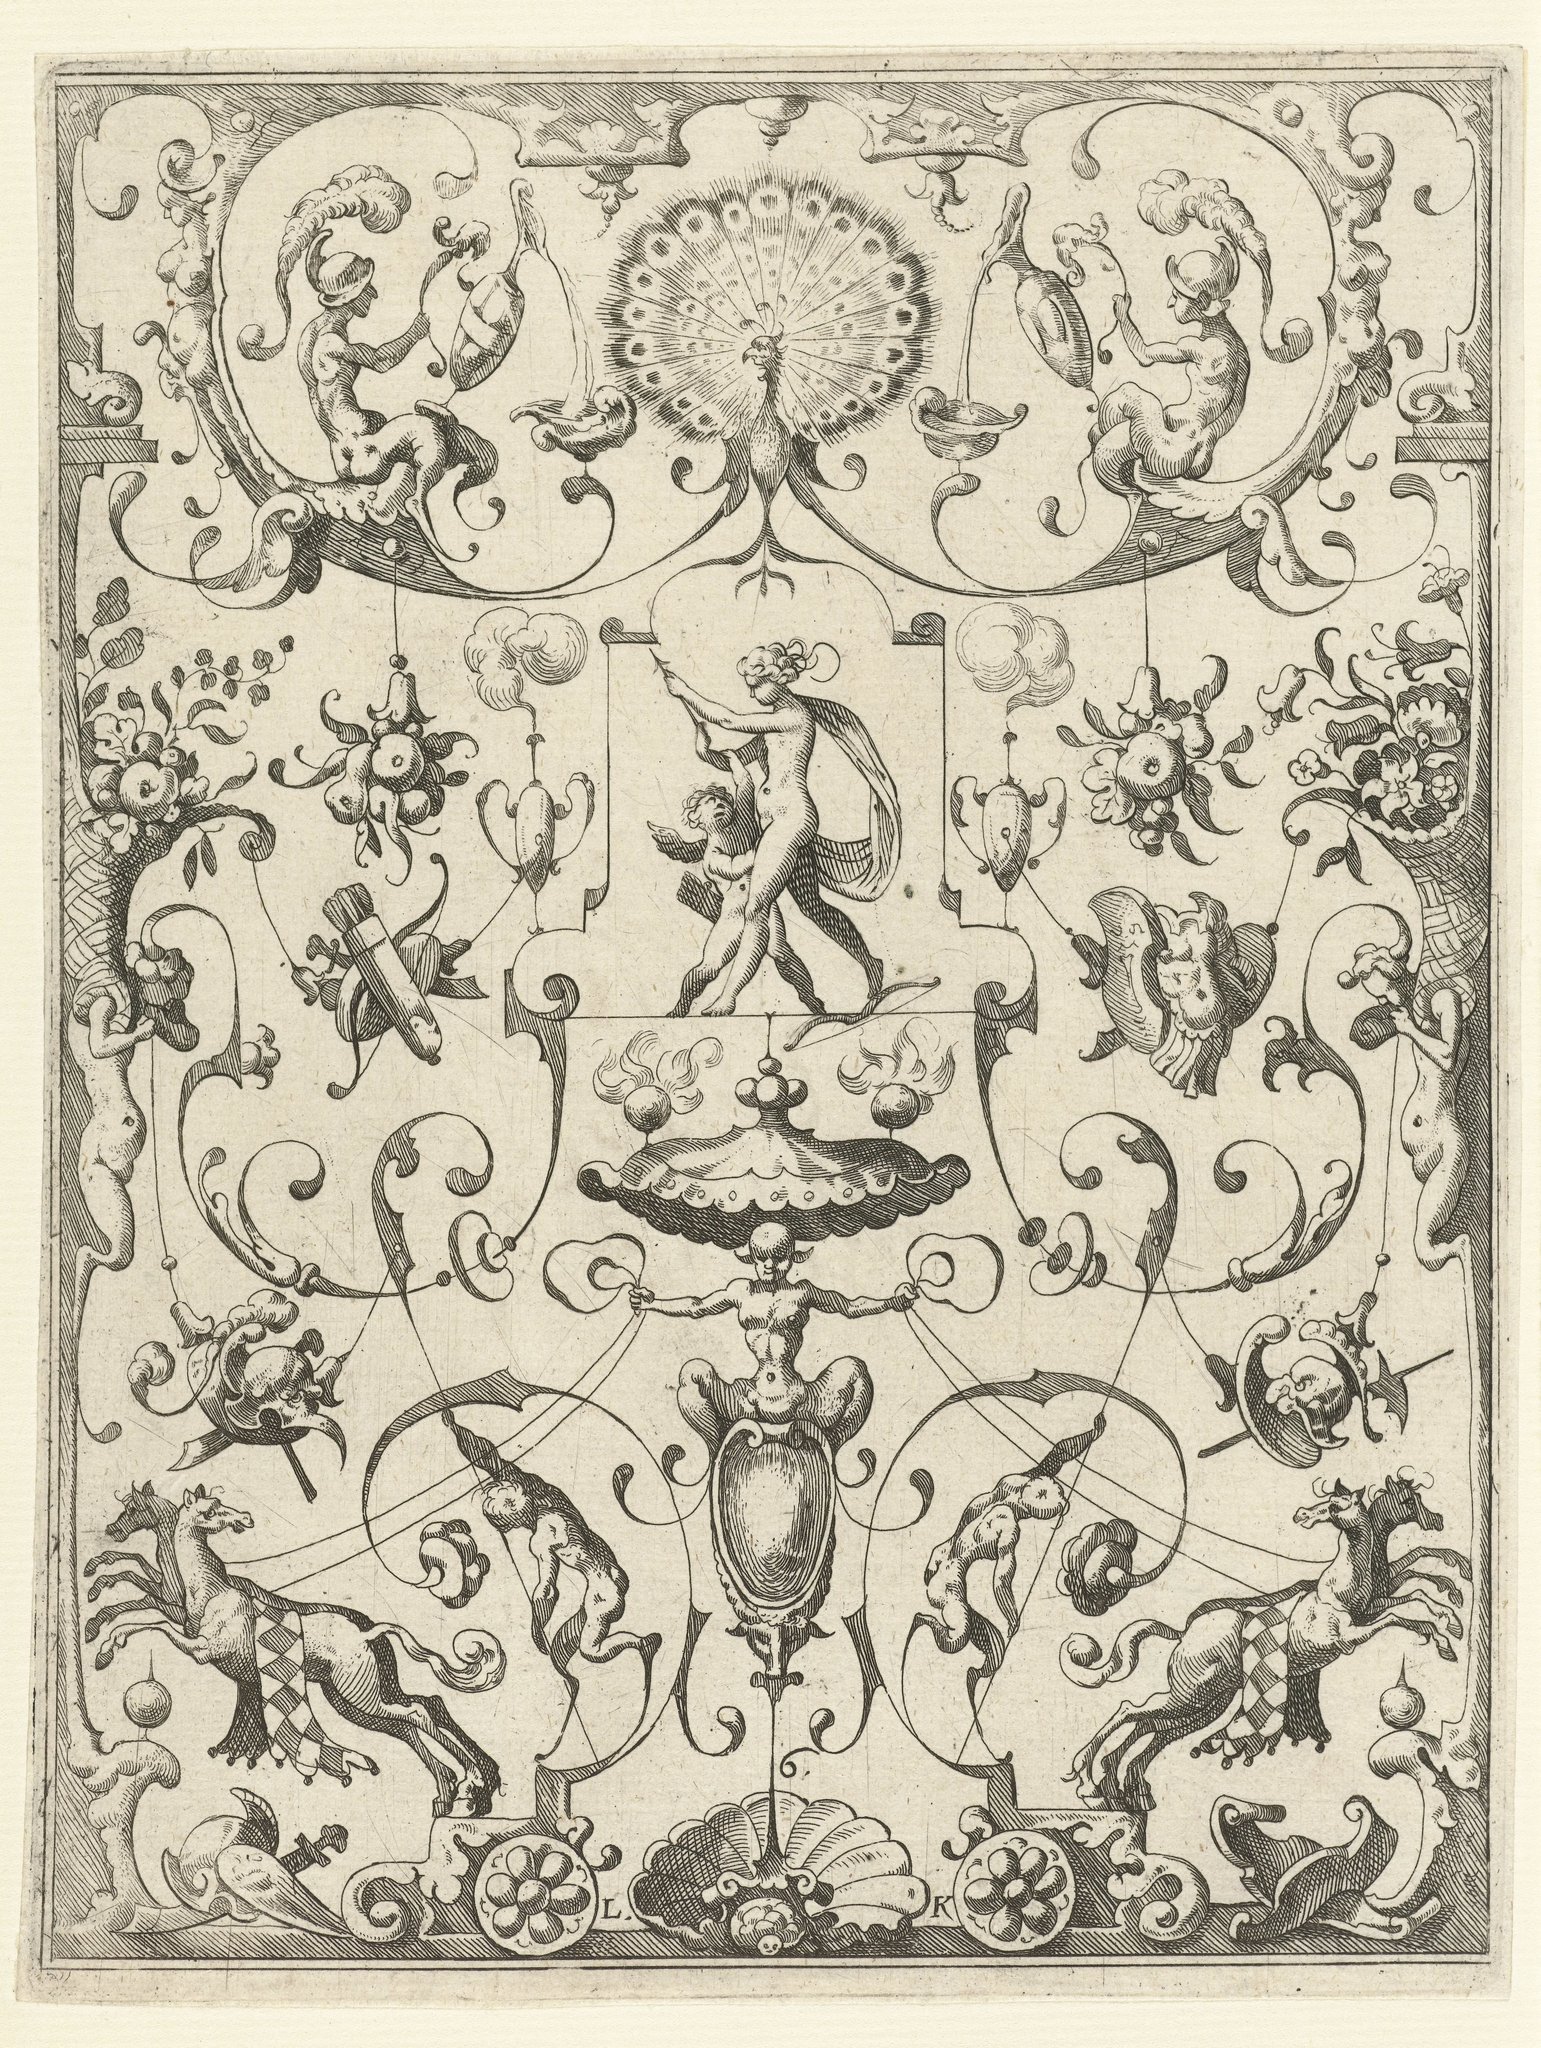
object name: print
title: Vlakdecoratie met grotesken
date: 1607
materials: paper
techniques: etching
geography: germany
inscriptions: collector's mark: Lugt 240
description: In het midden pakt Venus een pijl van Cupido af, terwijl zijn boog naar beneden valt. Blad 6 uit serie met groteske vlakdecoraties met kwabornamenten.